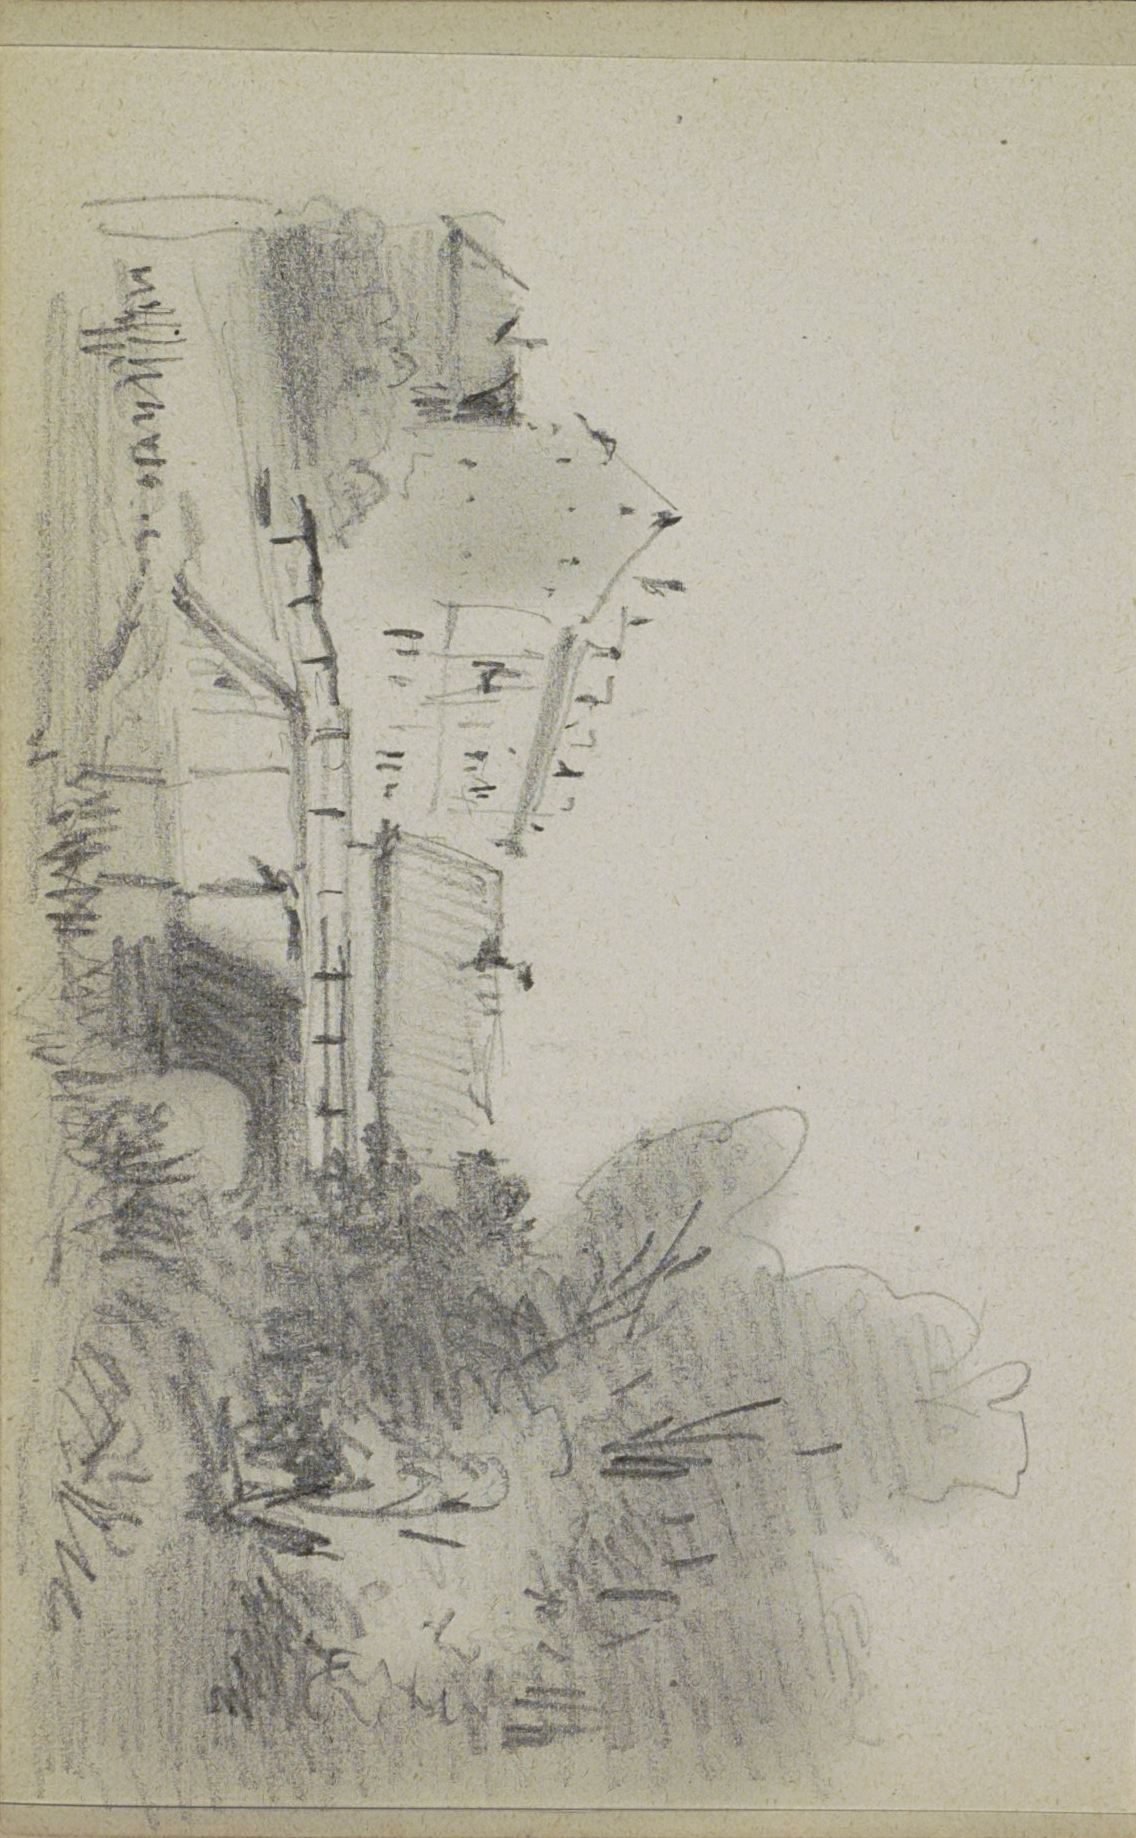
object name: sketchbook leaf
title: Gezicht op gebouwen bij een brug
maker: adrianus eversen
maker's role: draughtsman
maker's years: 1818-1897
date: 1828-1897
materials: paper, pencil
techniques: stumping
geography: netherlands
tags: landscapes with waters, waterscapes, seascapes (in the temperate zone), bridge in city across river, canal, etc., civic architecture; edifices; dwellings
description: Links gebouwen aan het water. Over het water een brug. Rechts bomen. Blad 51 verso uit een schetsboek met 58 bladen.